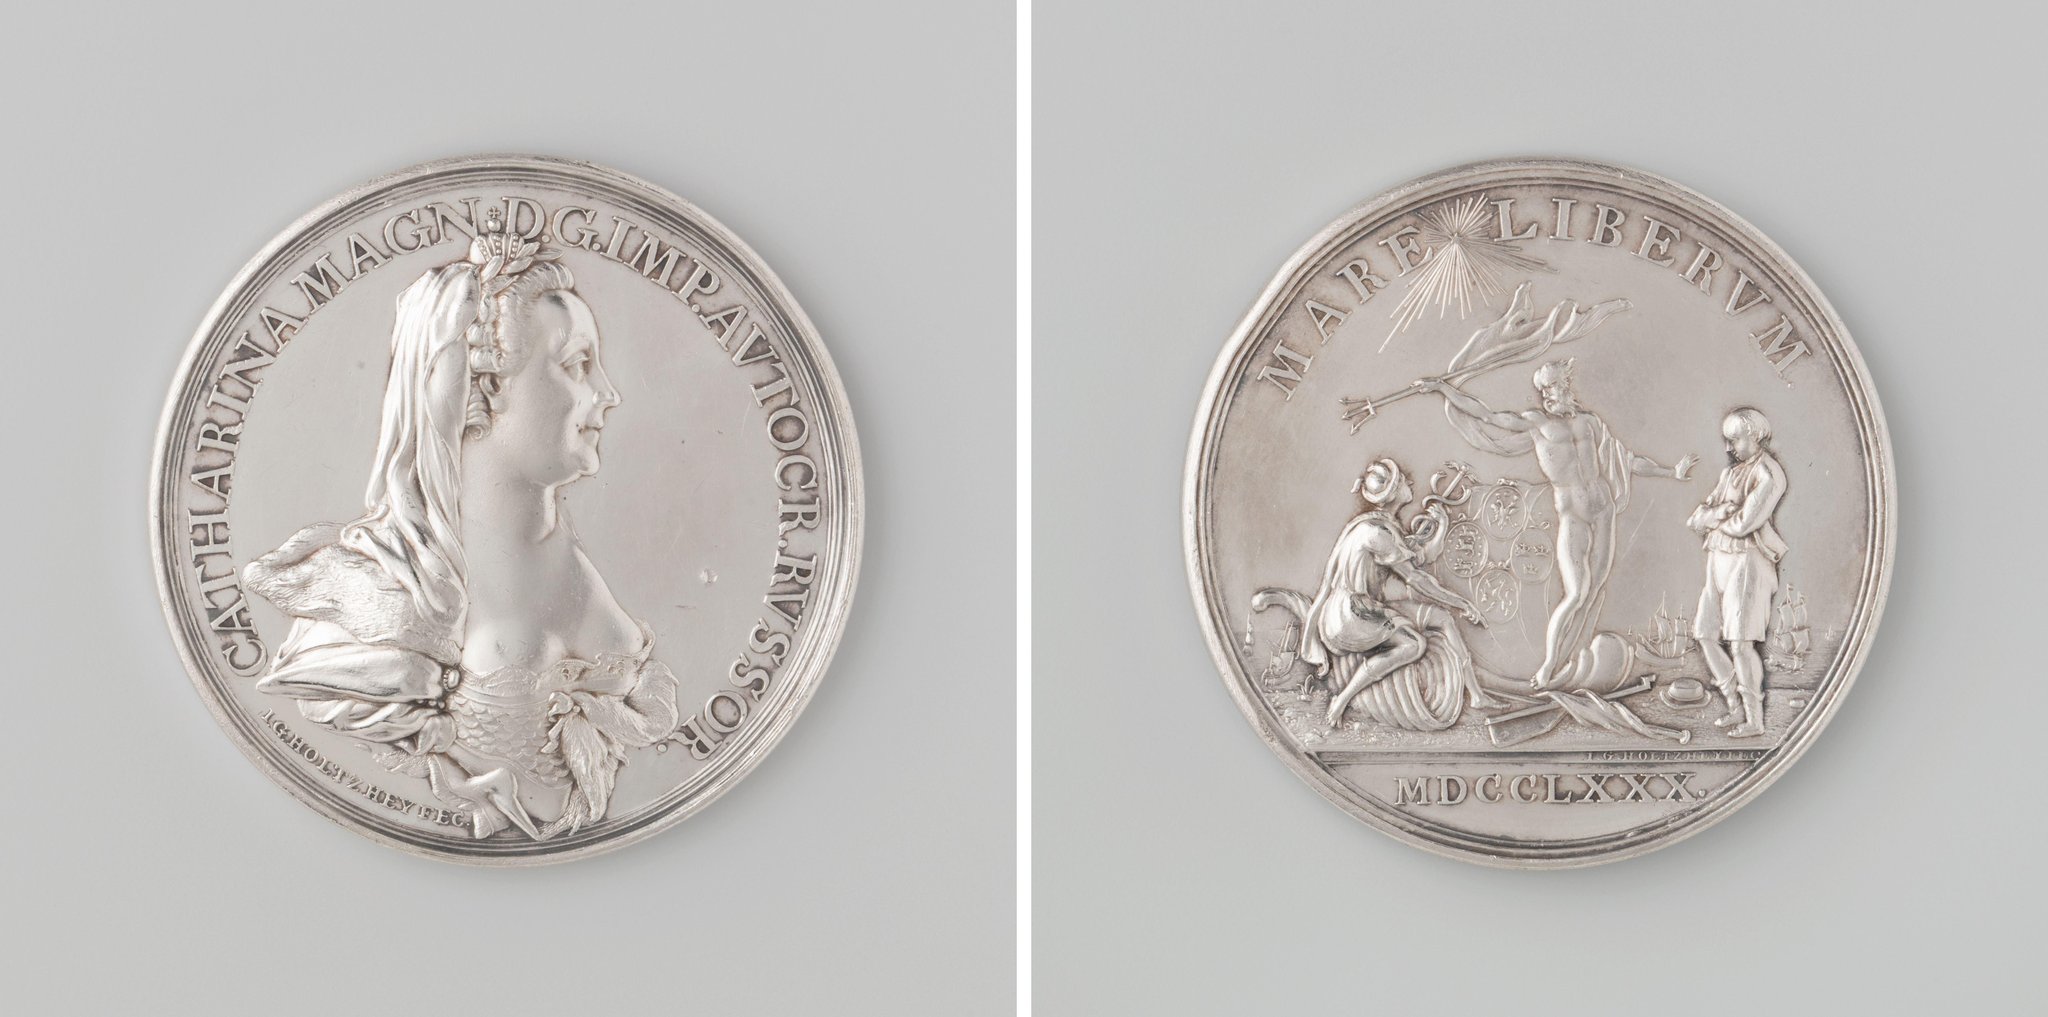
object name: history medal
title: Verbond van Gewapende Neutraliteit, tussen Rusland, Denemarken, Zweden en de Nederlanden, ter ere van Catharina II de Grote, tsarina van Rusland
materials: silver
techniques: striking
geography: amsterdam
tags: catharina de grote